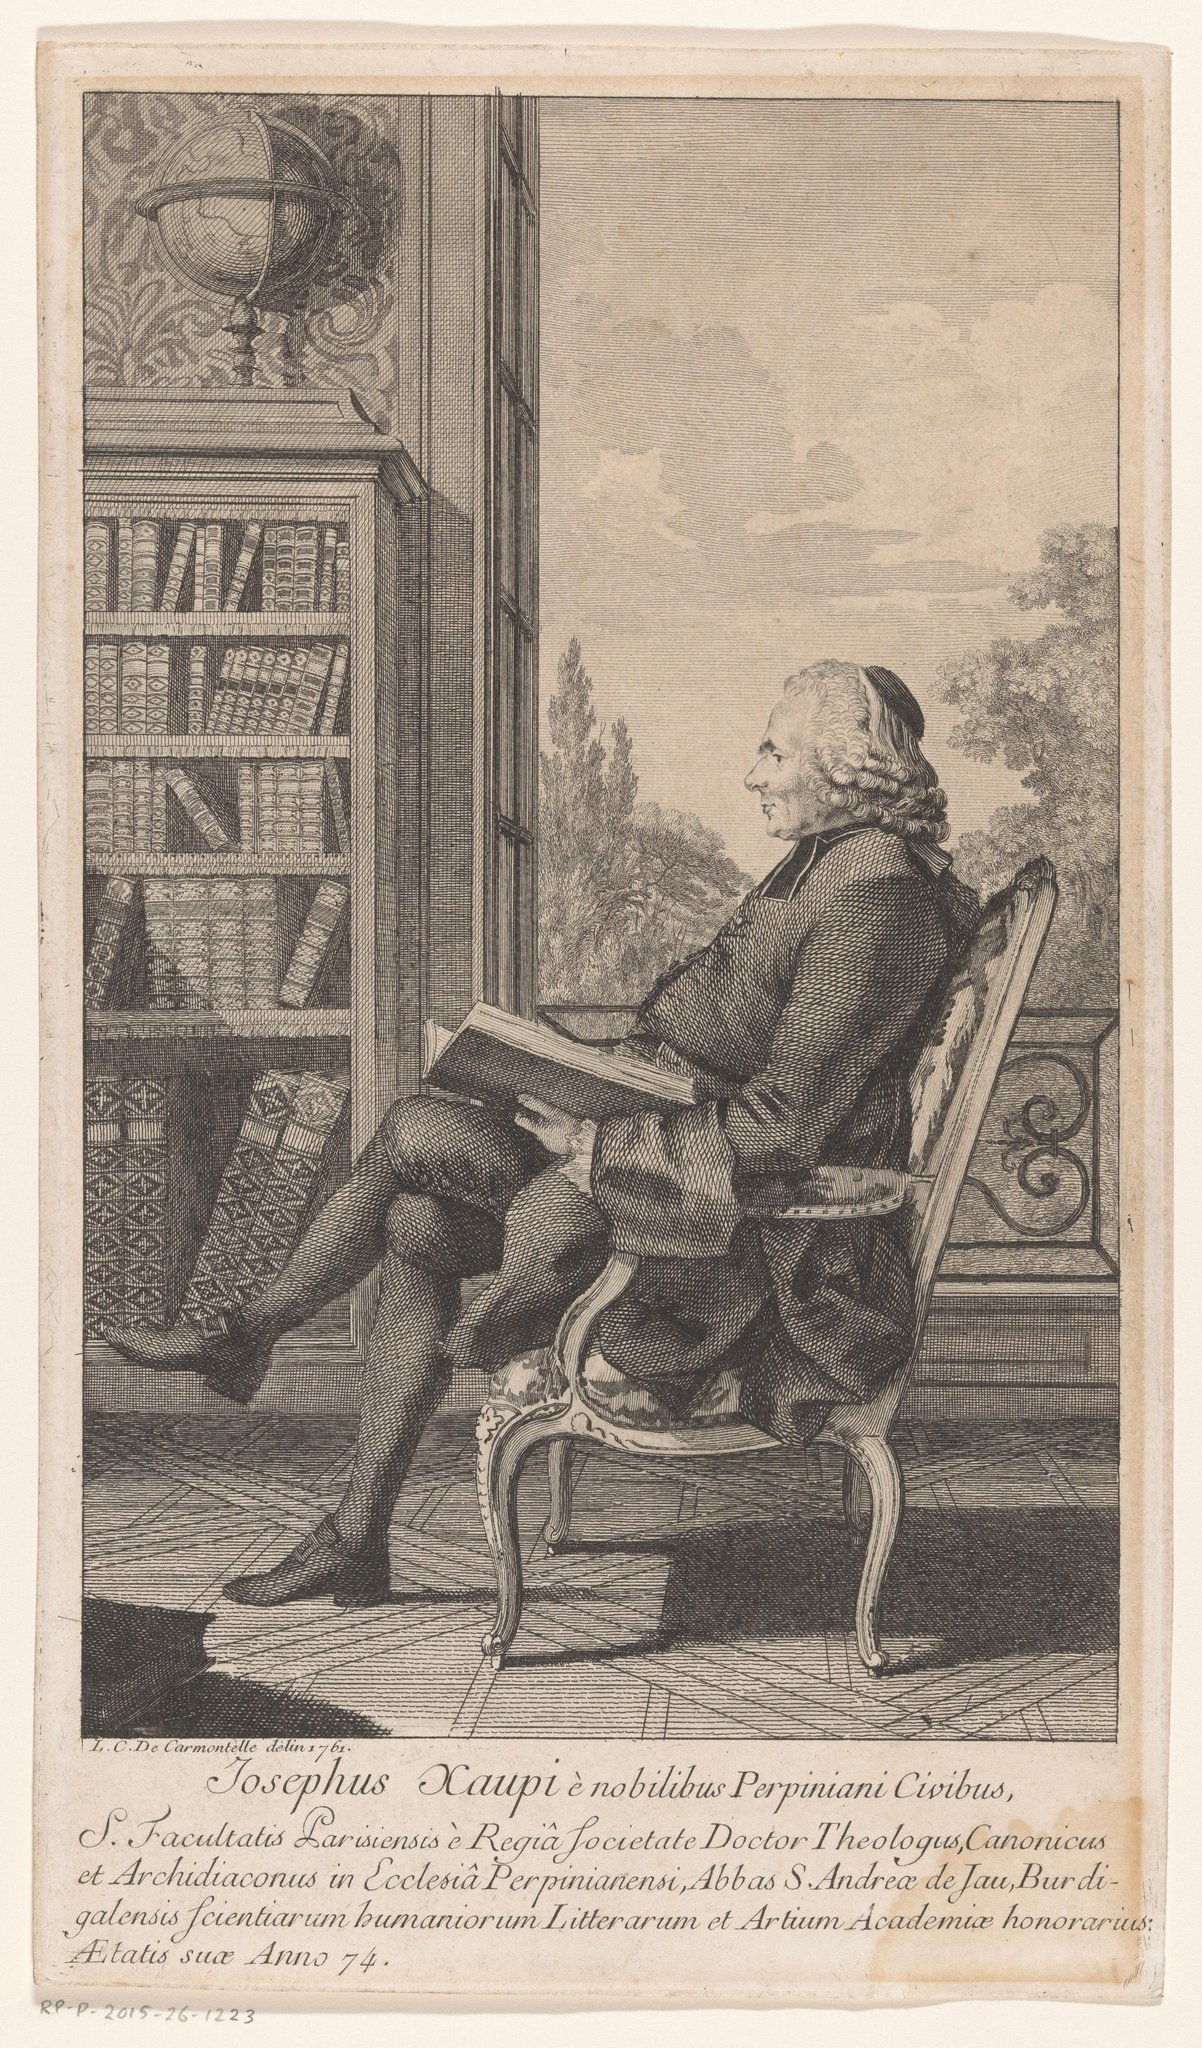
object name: print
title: Portret van Joseph Xaupi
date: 1761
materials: paper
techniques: engraving, etching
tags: paris, clergyman, bookshelves, writer, poet, author, organization, functionaries and dignitaries in roman catholic church; clergy in general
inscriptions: collector's mark: Lugt 2228, collector's mark: Lugt 1669f, collector's mark: Lugt 1669e, collector's mark: ‘L.A. de Vries’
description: Portret van de Franse auteur en geestelijke Joseph Xaupi, zittend in een stoel met een boek in zijn schoot voor een geopend raam. Naast hem een boekenkast met bovenop een globe.